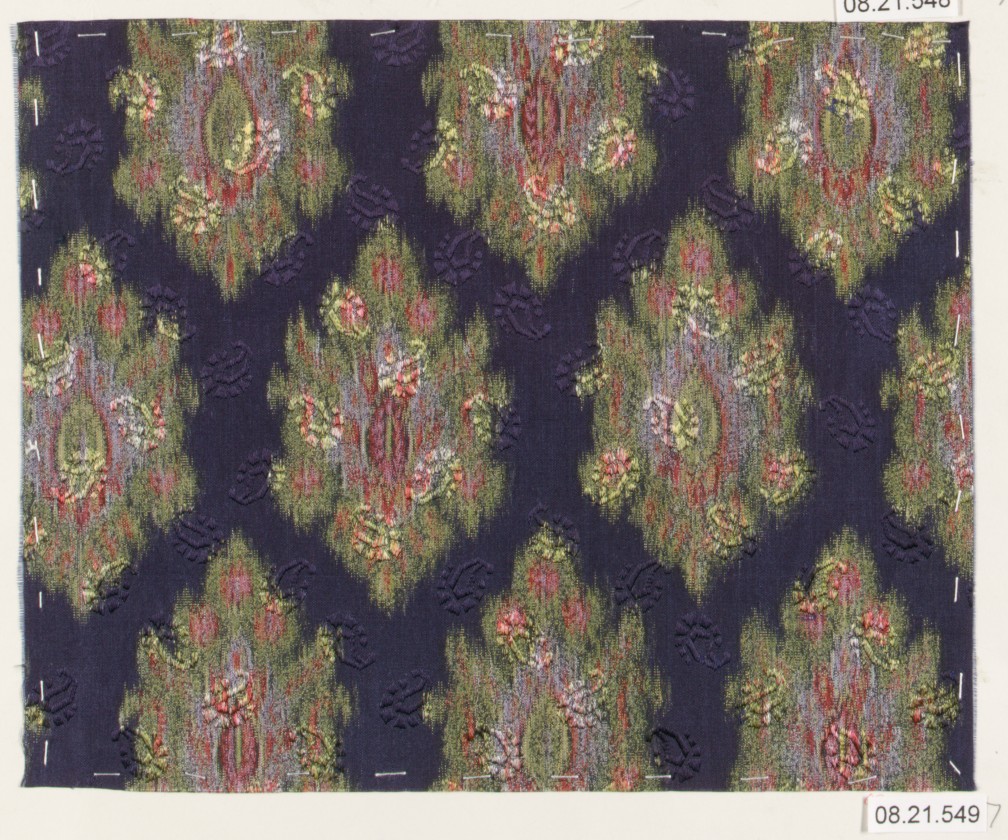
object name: textile sample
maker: Anonymous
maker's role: designer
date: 1900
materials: silk